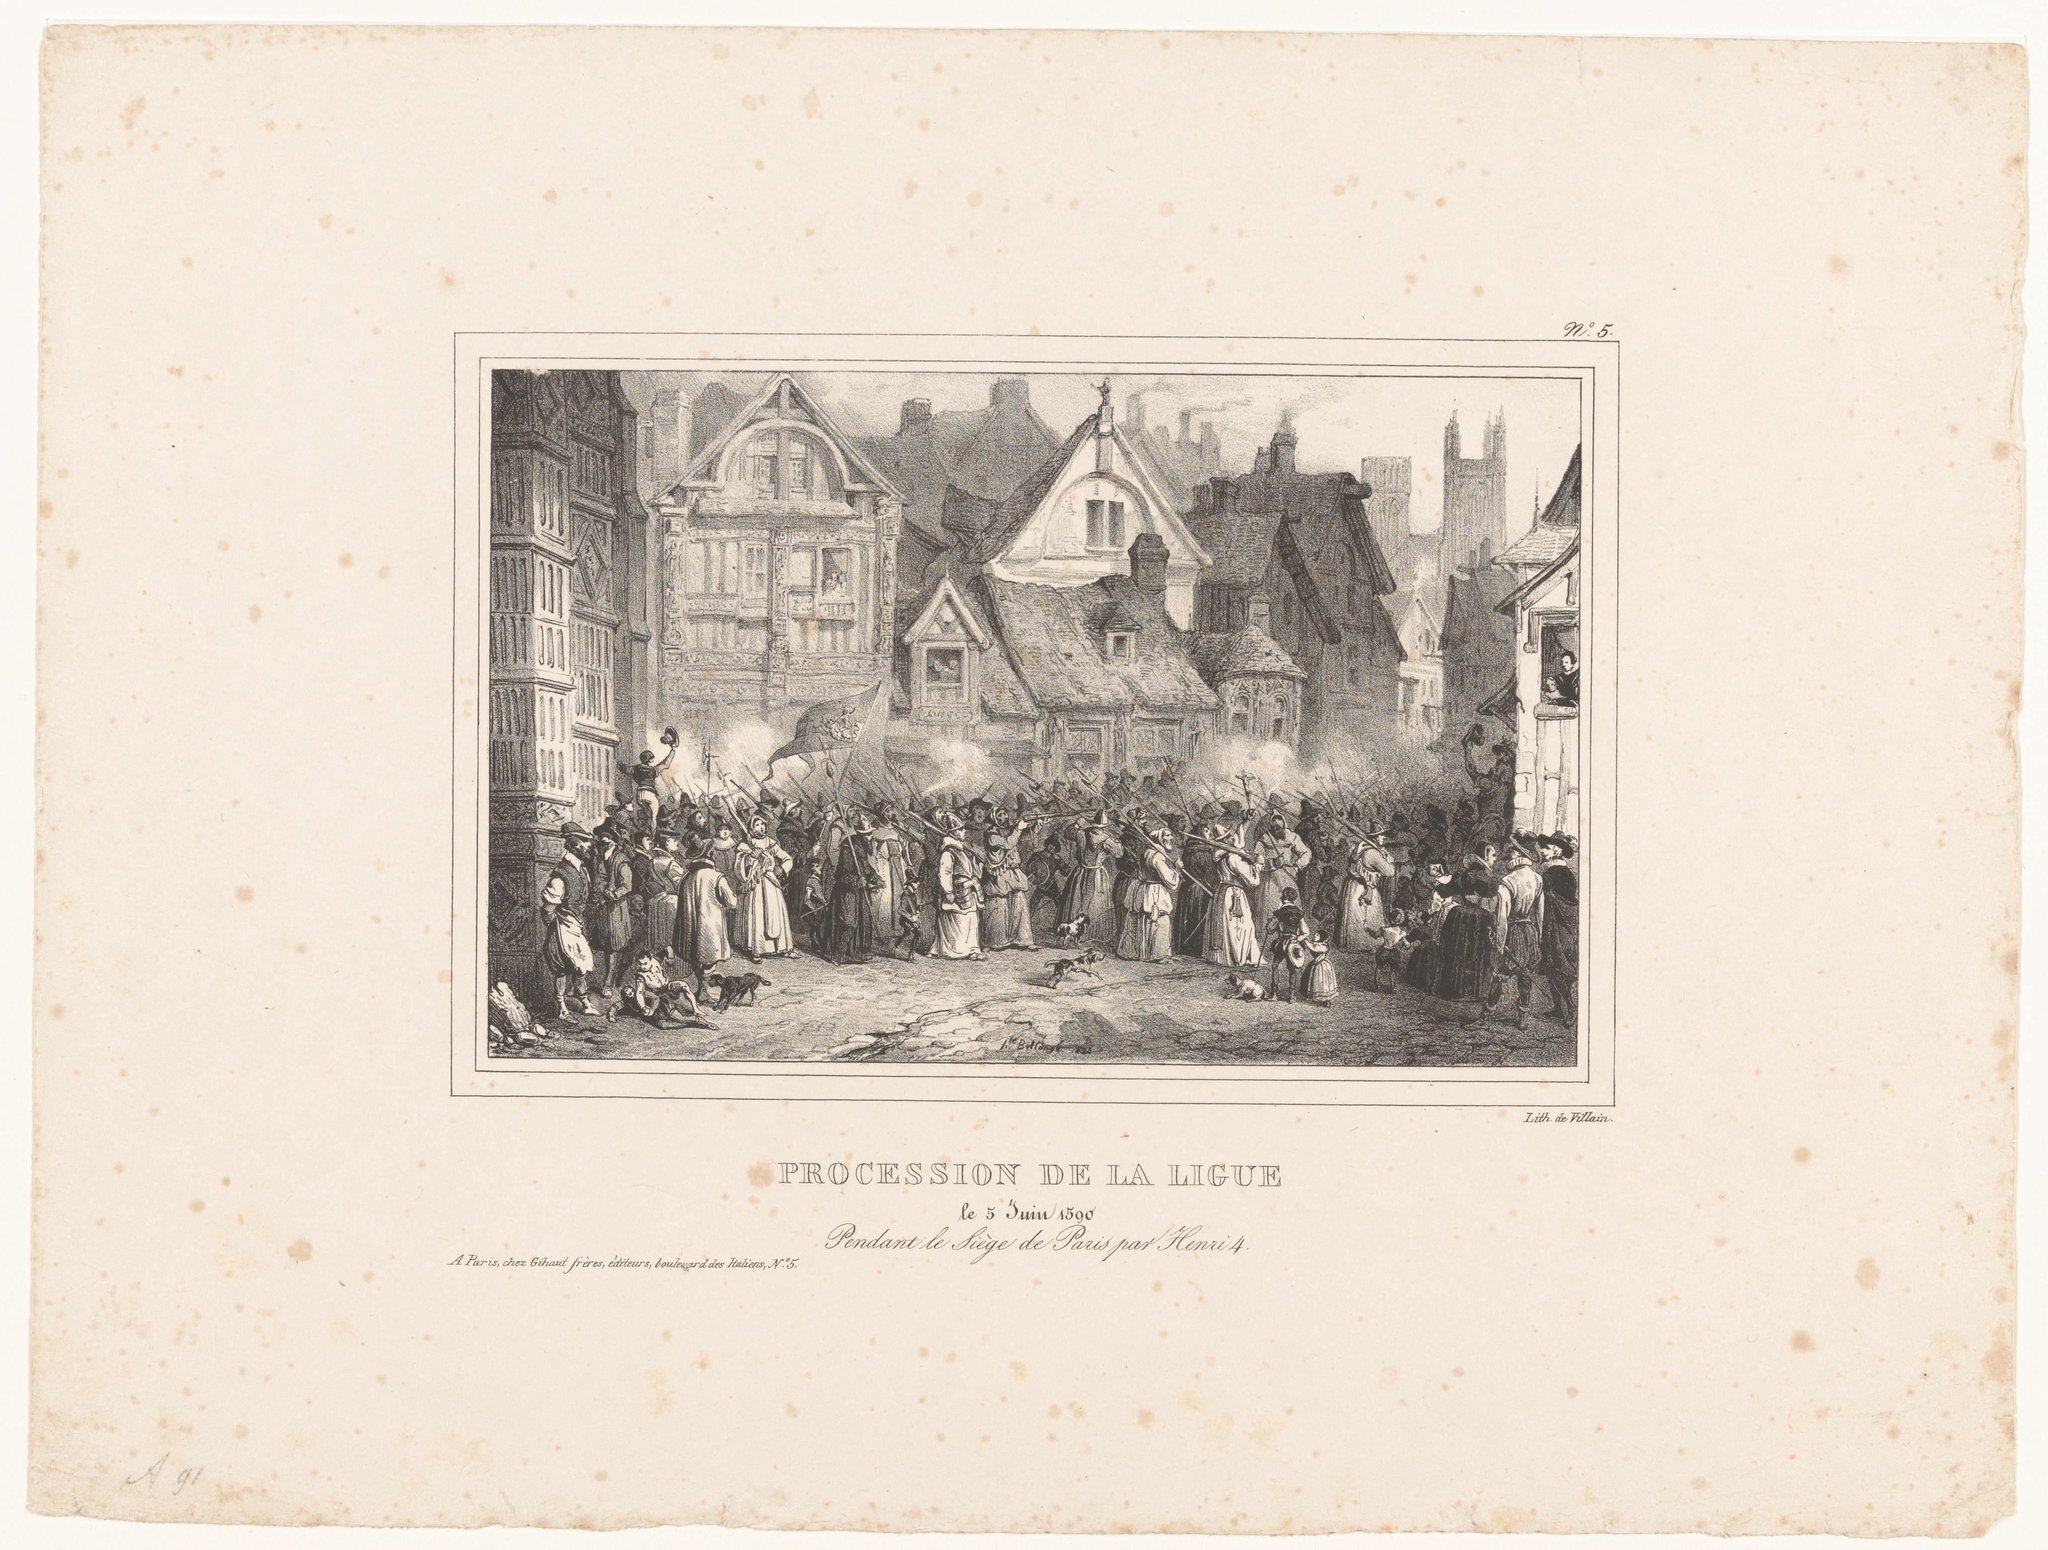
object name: print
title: Processie van de Heilige Liga tijdens het beleg van Parijs in 1590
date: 1828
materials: paper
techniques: lithograph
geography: paris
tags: siege, position war, procession ~ christian religion, paris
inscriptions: collector's mark: Lugt 2228a